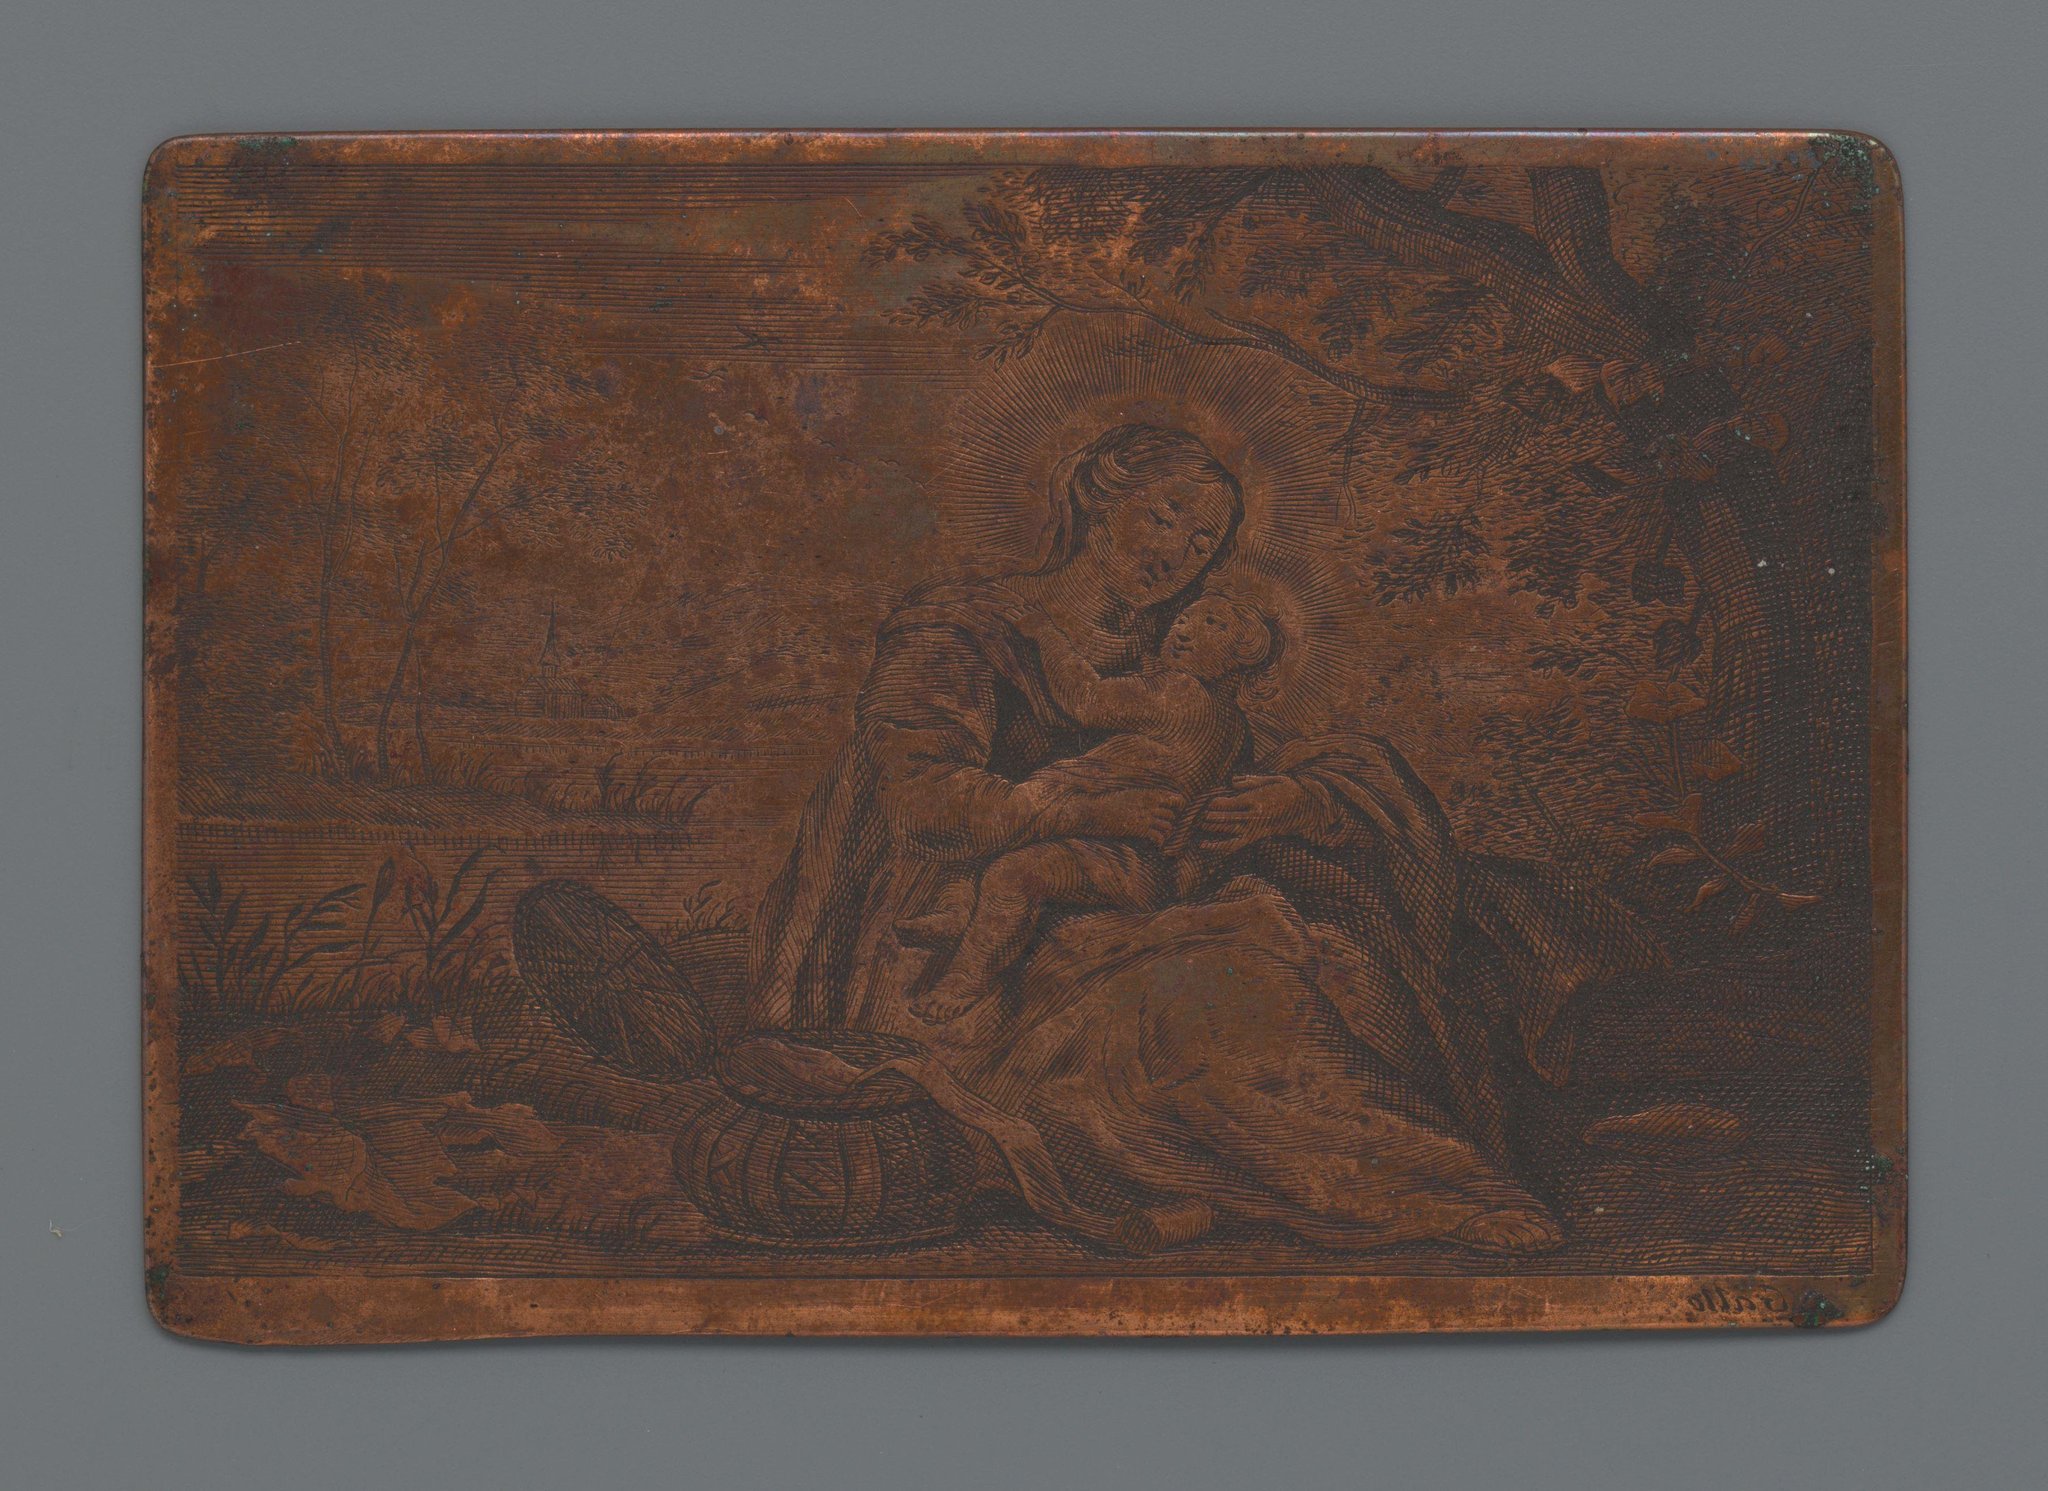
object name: copper plate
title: Koperplaat met Maria met kind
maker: gaspar huybrechts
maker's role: print maker, publisher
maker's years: 1619-1684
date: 1610-1678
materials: copper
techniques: engraving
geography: antwerp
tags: christ-child throwing his arm(s) around her neck ~ madonna-representations, christ-child looking or turning to mary ~ madonna-representations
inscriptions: signature: ‘Galle’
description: De platen (RP-D-2014-9-1 t/m 35) zijn vrijwel allemaal vervaardigd door anonieme graveurs werkend voor de Antwerpse uitgevers Cornelis Galle, Frans Huberti (Huybrechts), Theodor van Merlen II en Michel Bunel. Vermoedelijk zijn ze uiteindelijk beland in één fonds, wellicht dat van Michel Bunel (1670-1739) en warden sindsdien bij elkaar bewaard. Afwijkend is de grote prent van Henry Verbruggen met een weergave van de Preekstoel uit de St. Gudule-kerk te Brussel. Twee prenten zijn verpakt in een oude afdruk van de prent, zoals te doen gebruikelijk in uitgeverijen (vergl. oude platen in Museum Plantijn Moretus, Antwerpen). Van 8 platen heeft de vorige eigenaar afdrukken laten maken op modern papier.